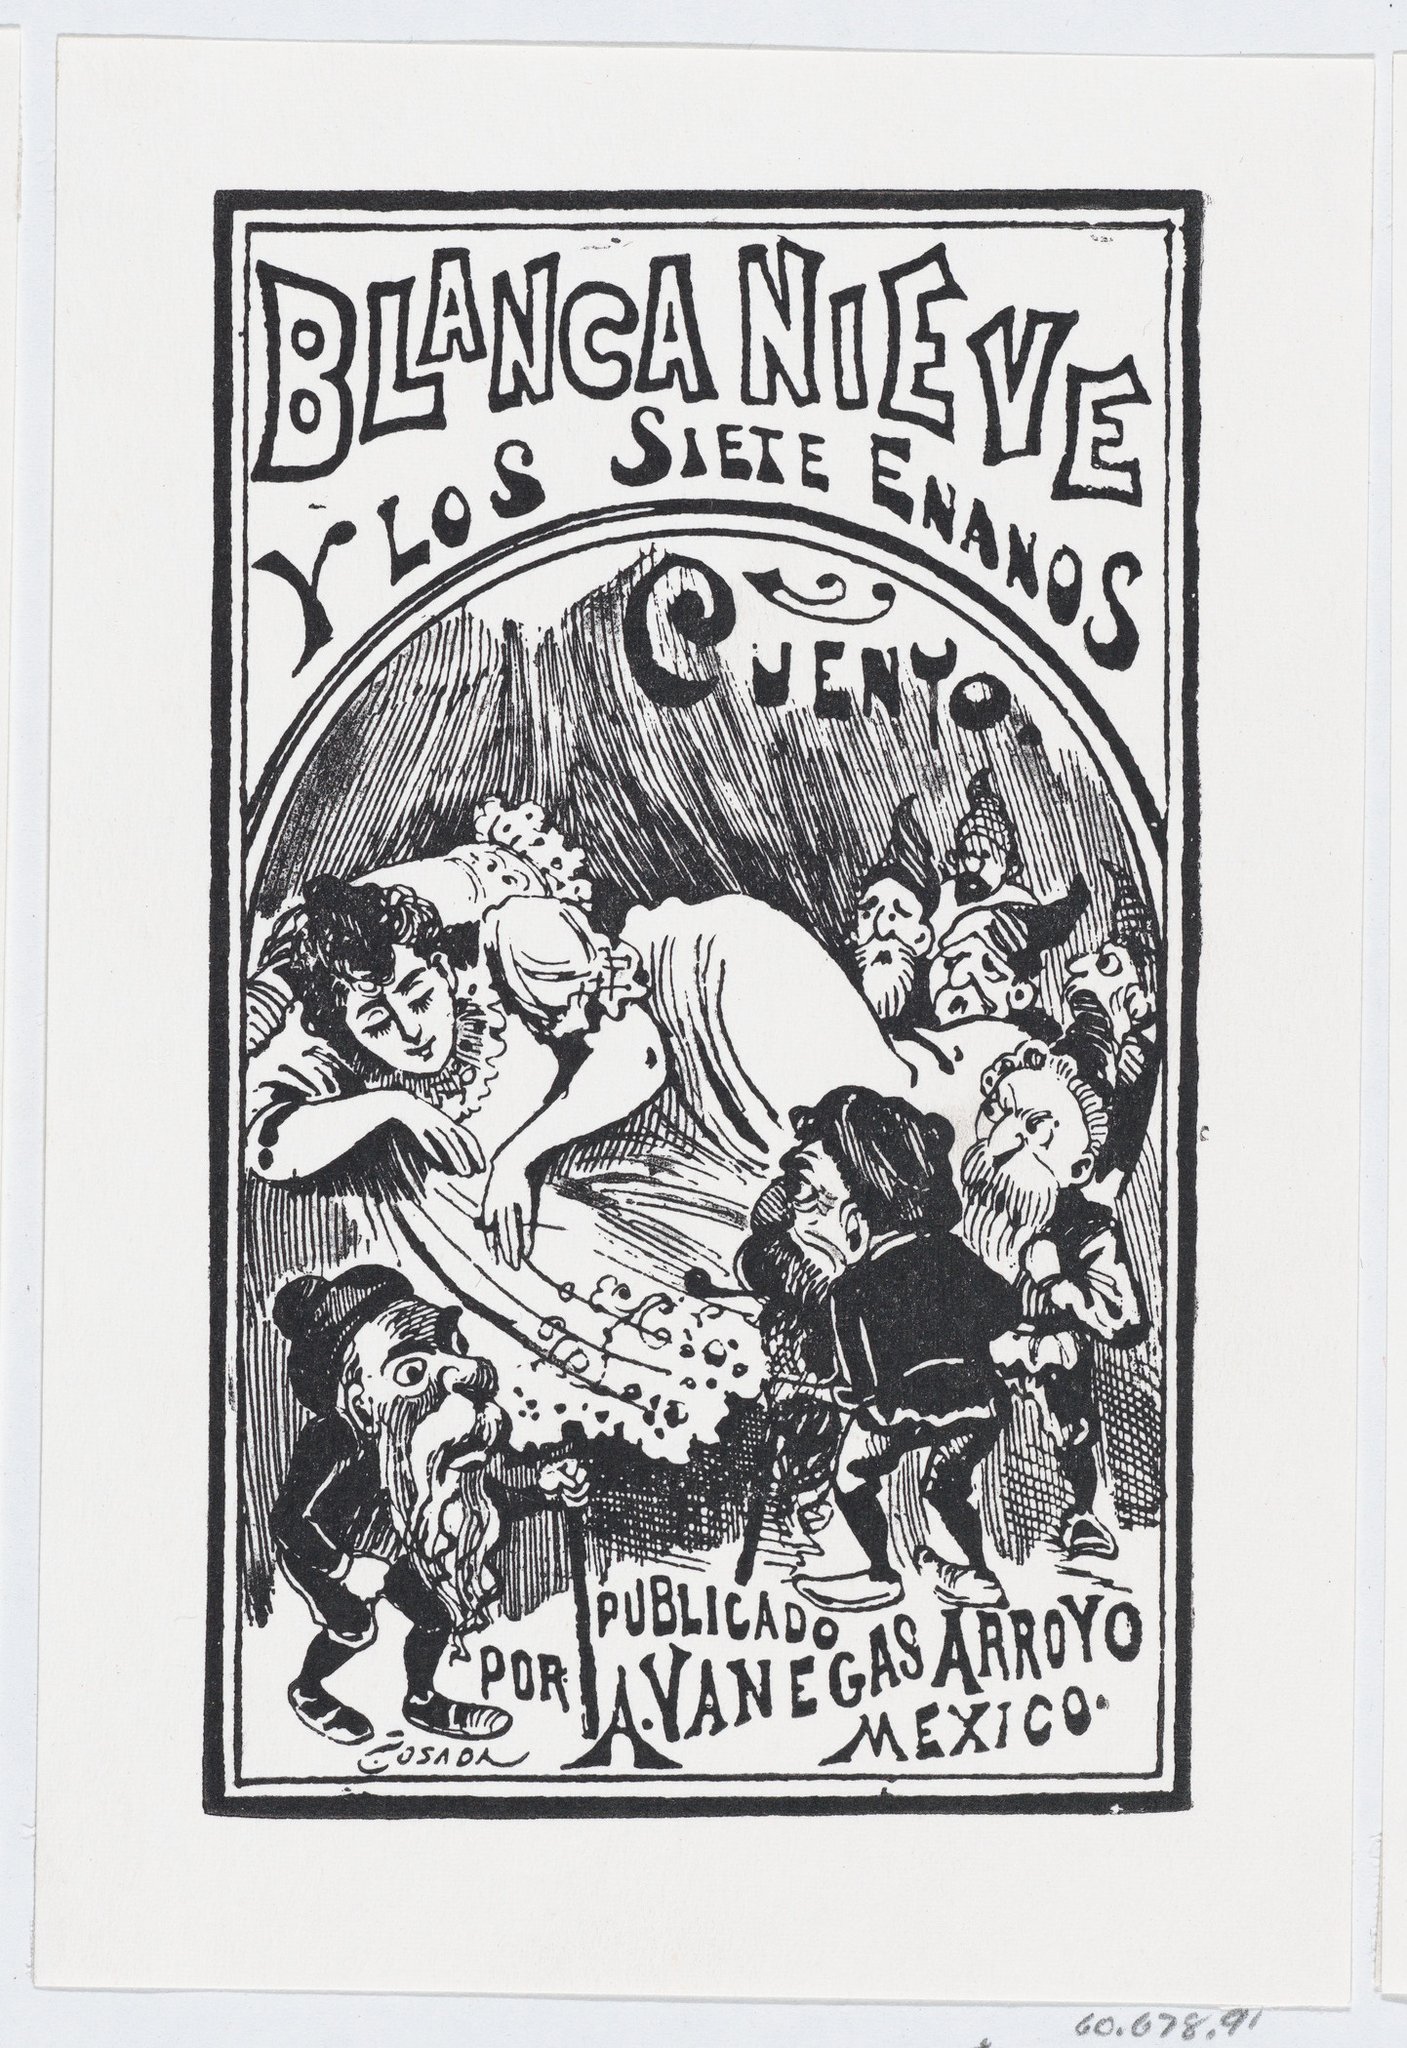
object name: print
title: Snow White and the Seven Dwarfs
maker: josé guadalupe posada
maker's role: artist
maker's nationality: mexican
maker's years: 1852-1913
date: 1898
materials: metal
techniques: engraving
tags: sleeping,men,women